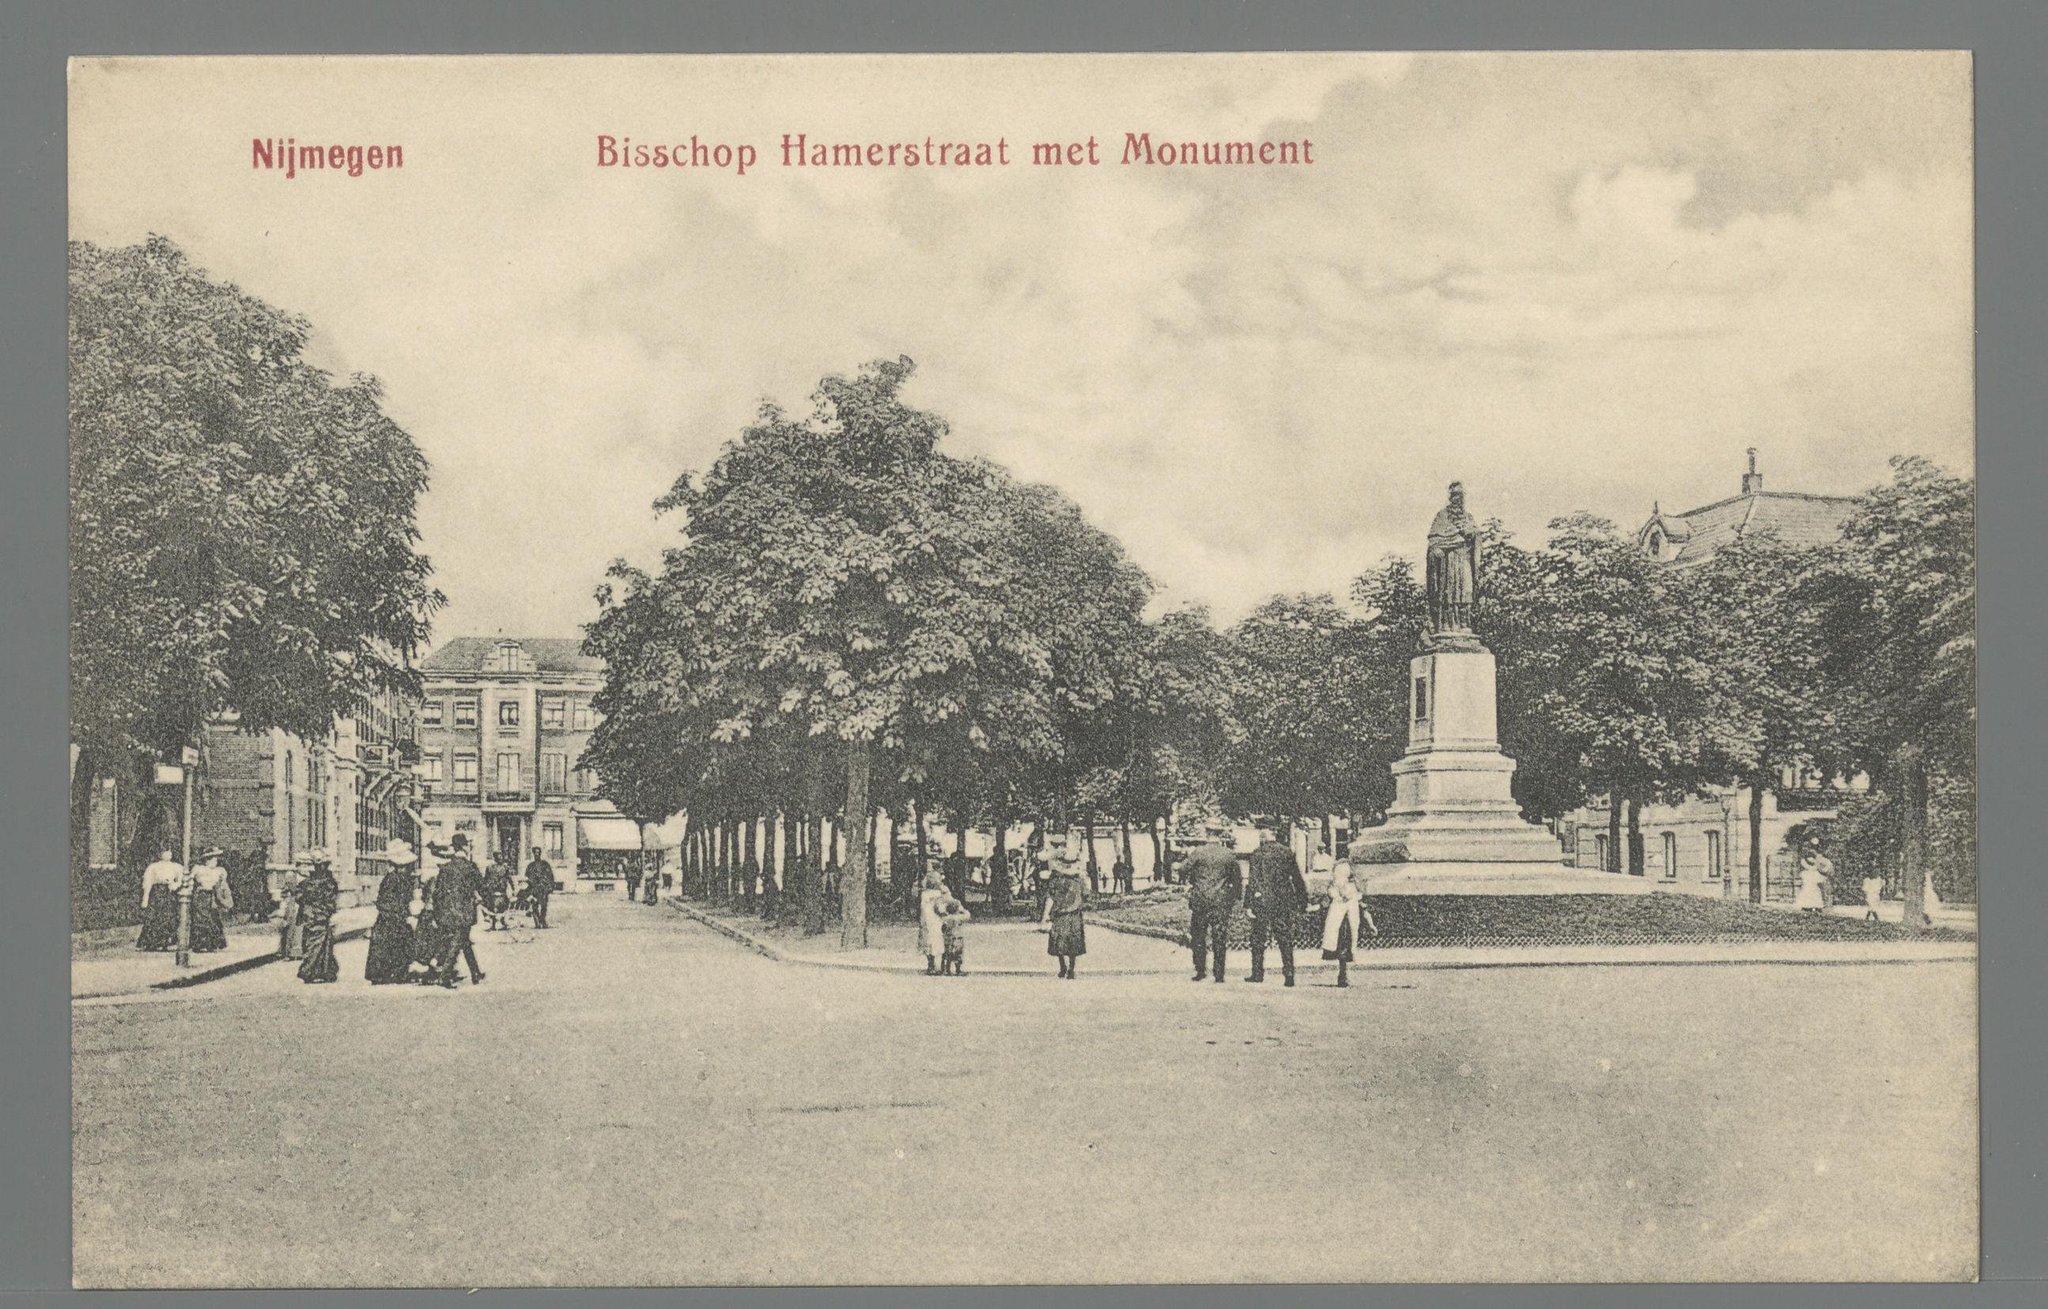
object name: ansichtkaart, prentbriefkaart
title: J.H. Schaefers Platino Edition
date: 1905-1926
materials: cardboard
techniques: photograph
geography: nijmegen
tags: monument, statue, street, nijmegen